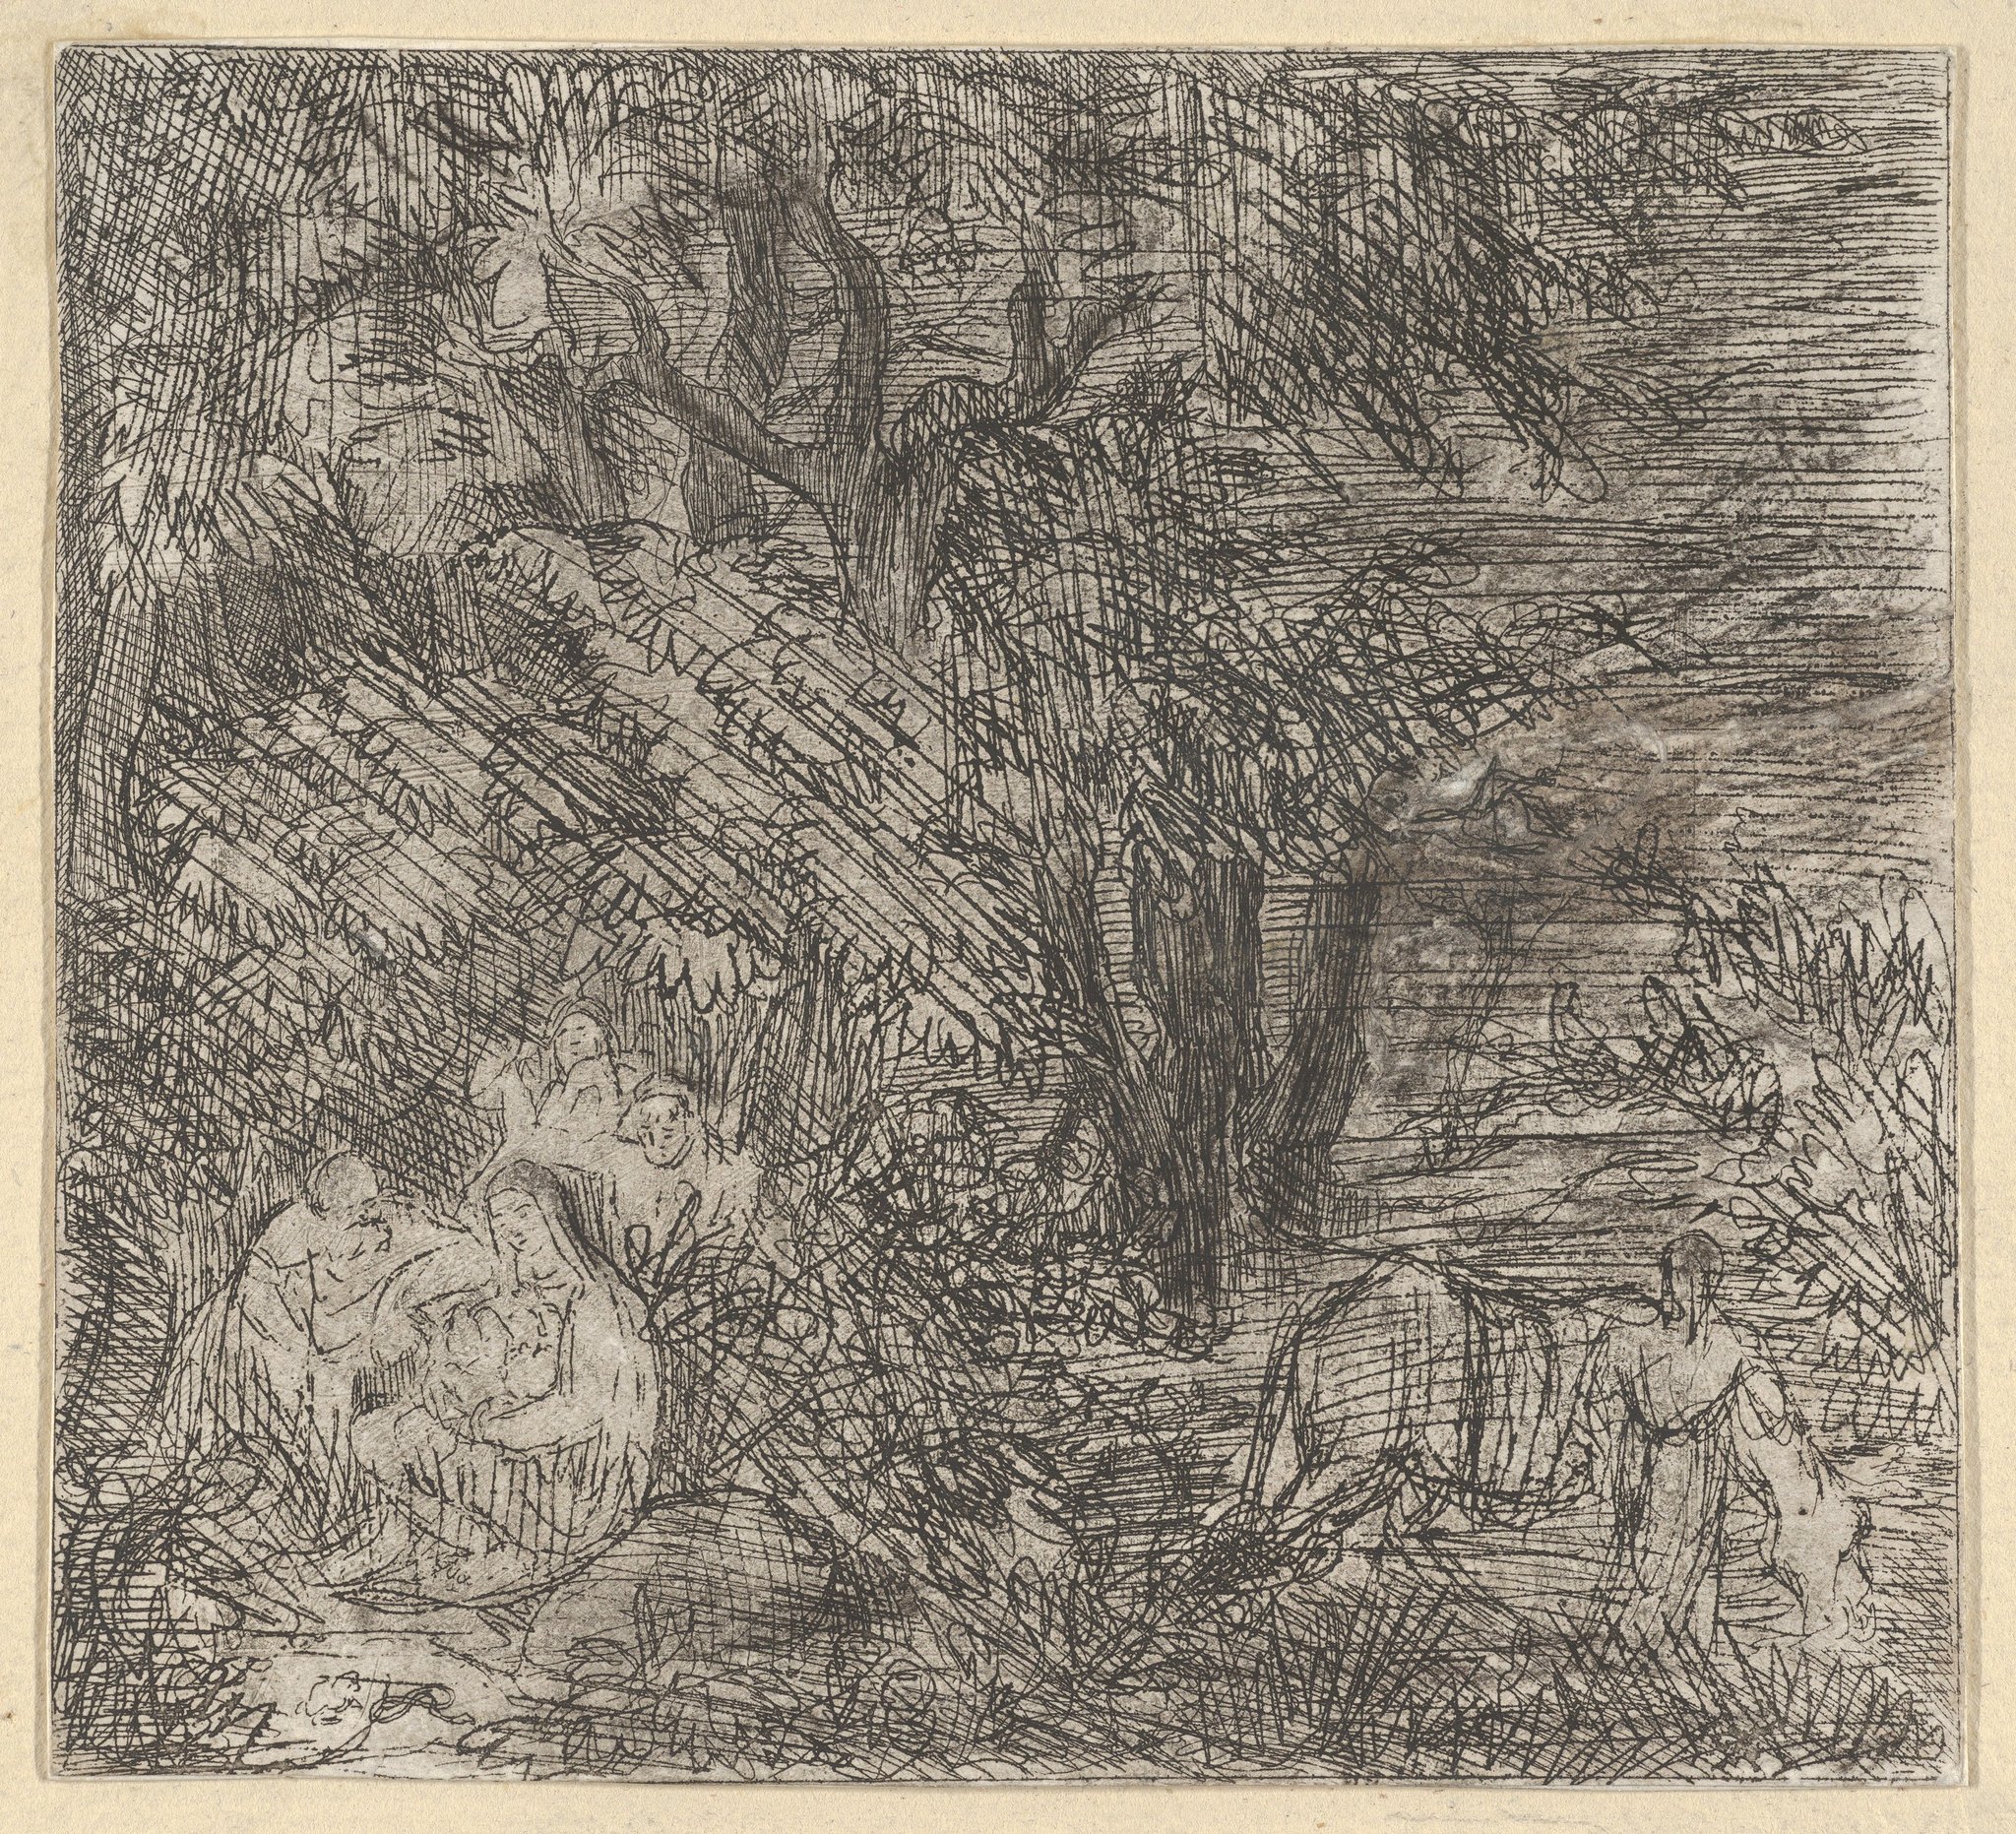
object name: print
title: La Sainte Famille (The Holy Family)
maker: rodolphe bresdin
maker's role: artist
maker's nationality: french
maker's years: 1822-1885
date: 1801-1900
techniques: etching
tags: holy family